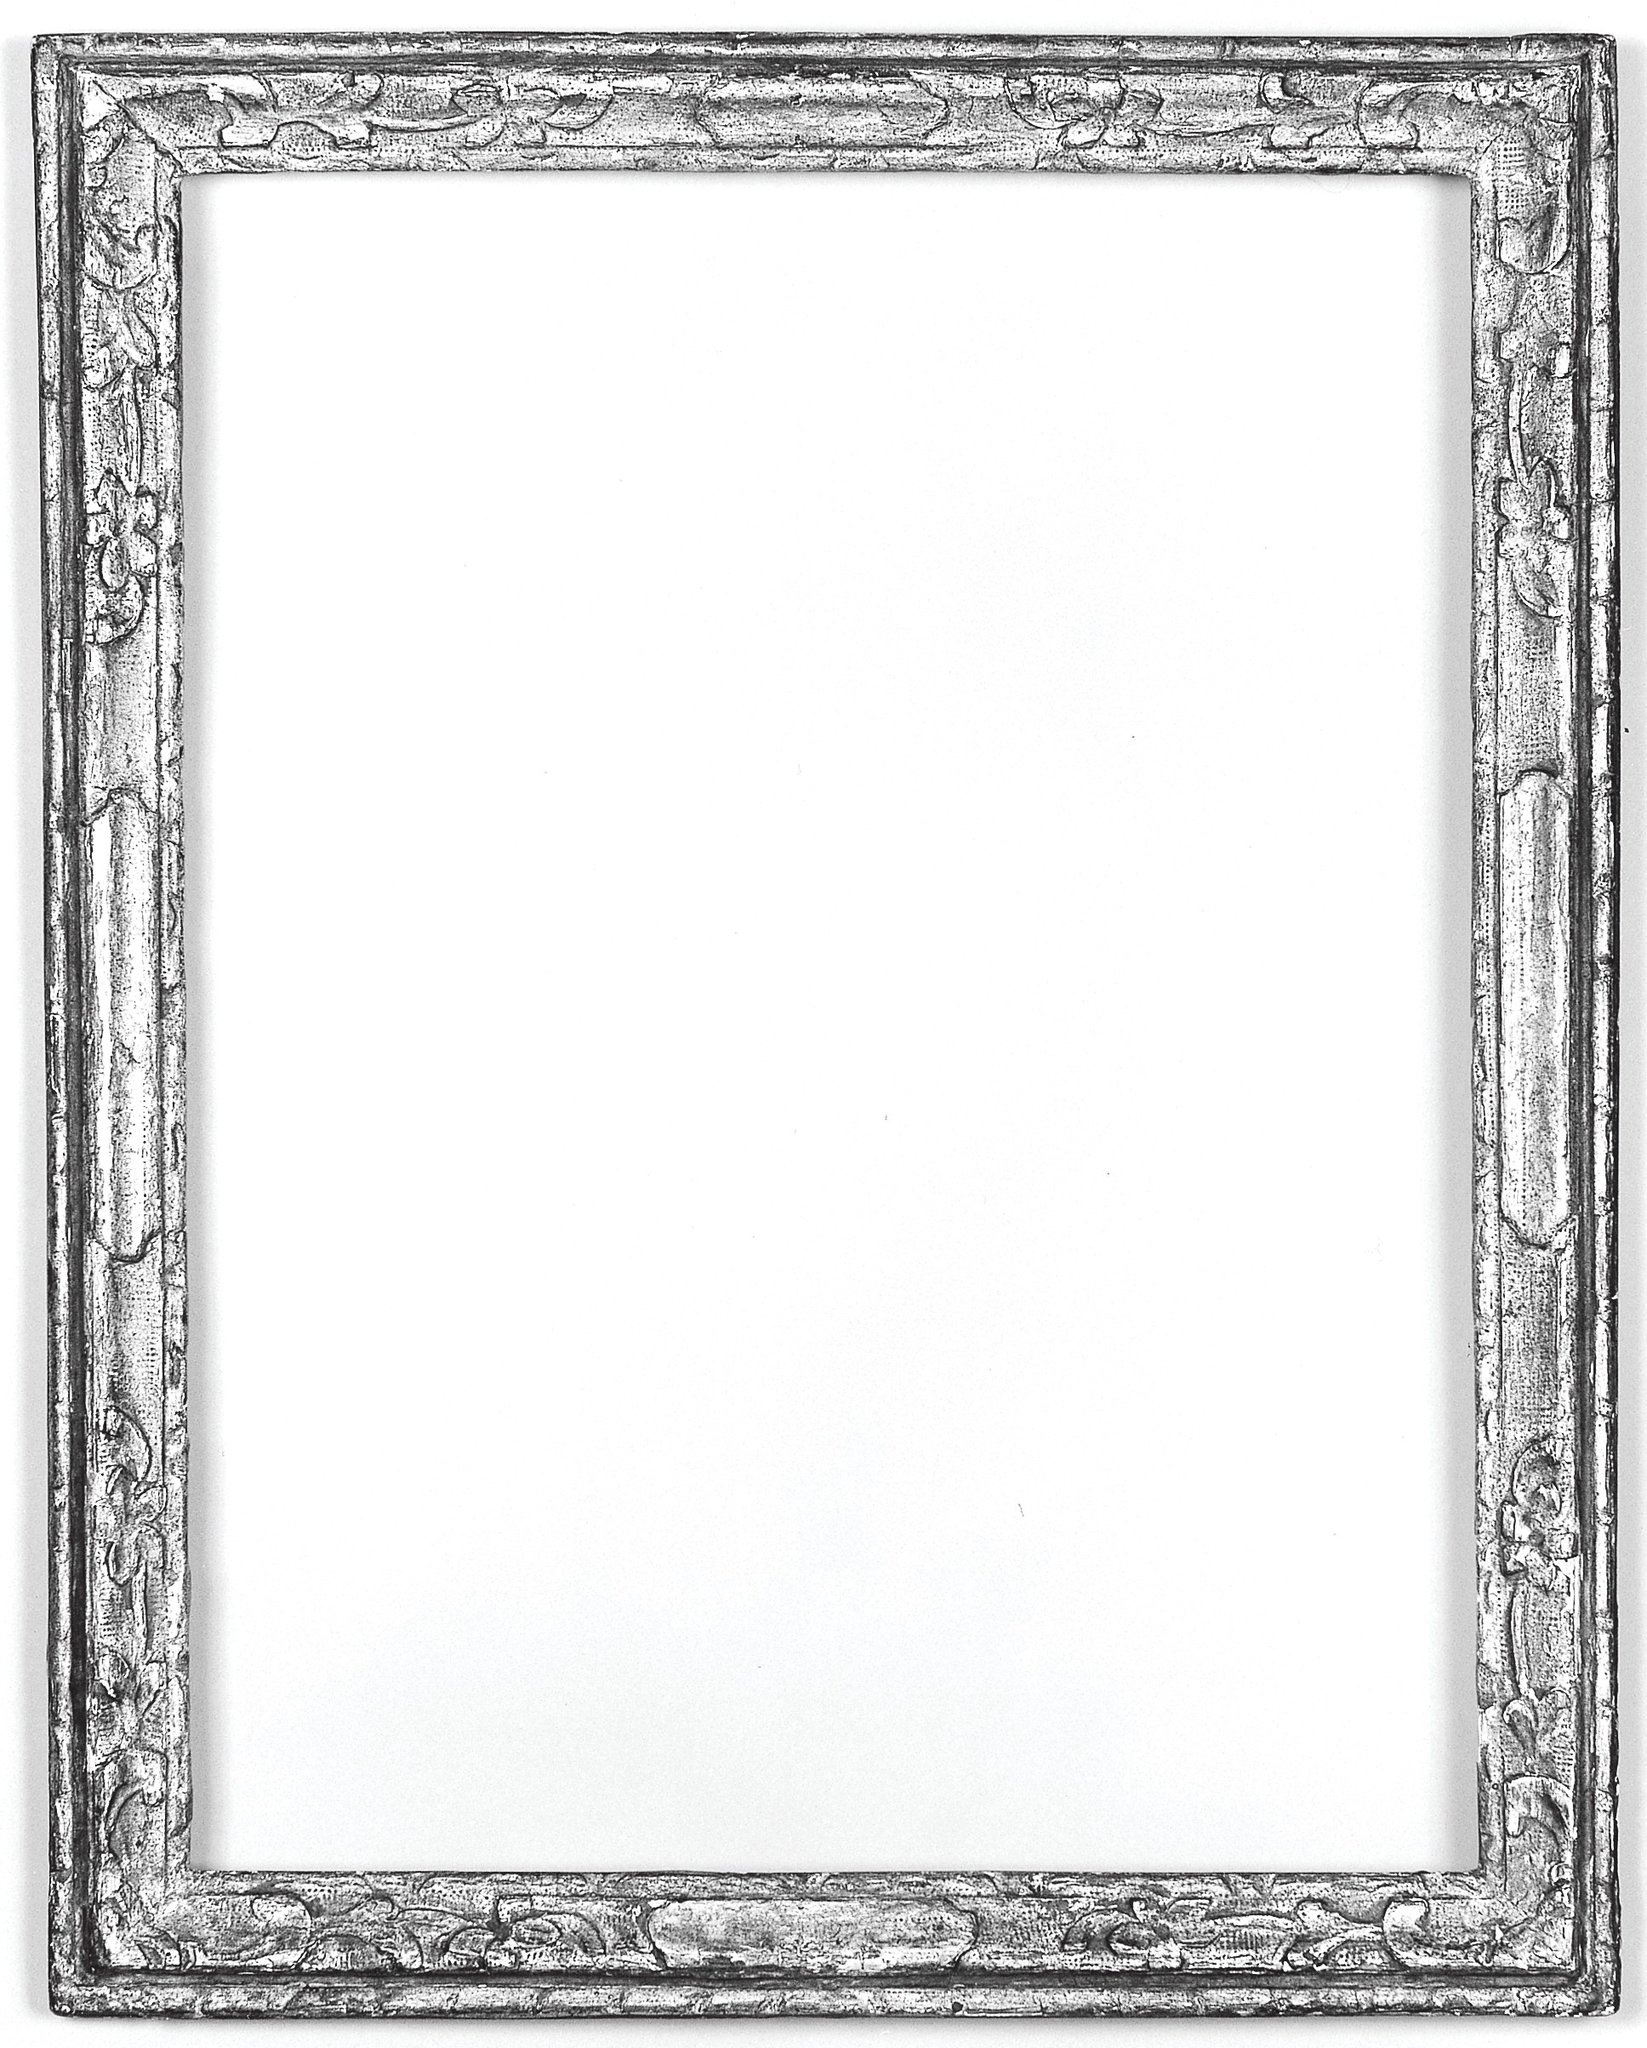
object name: frame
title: Canaletto-style frame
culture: italian, veneto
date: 1734-1766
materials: wood